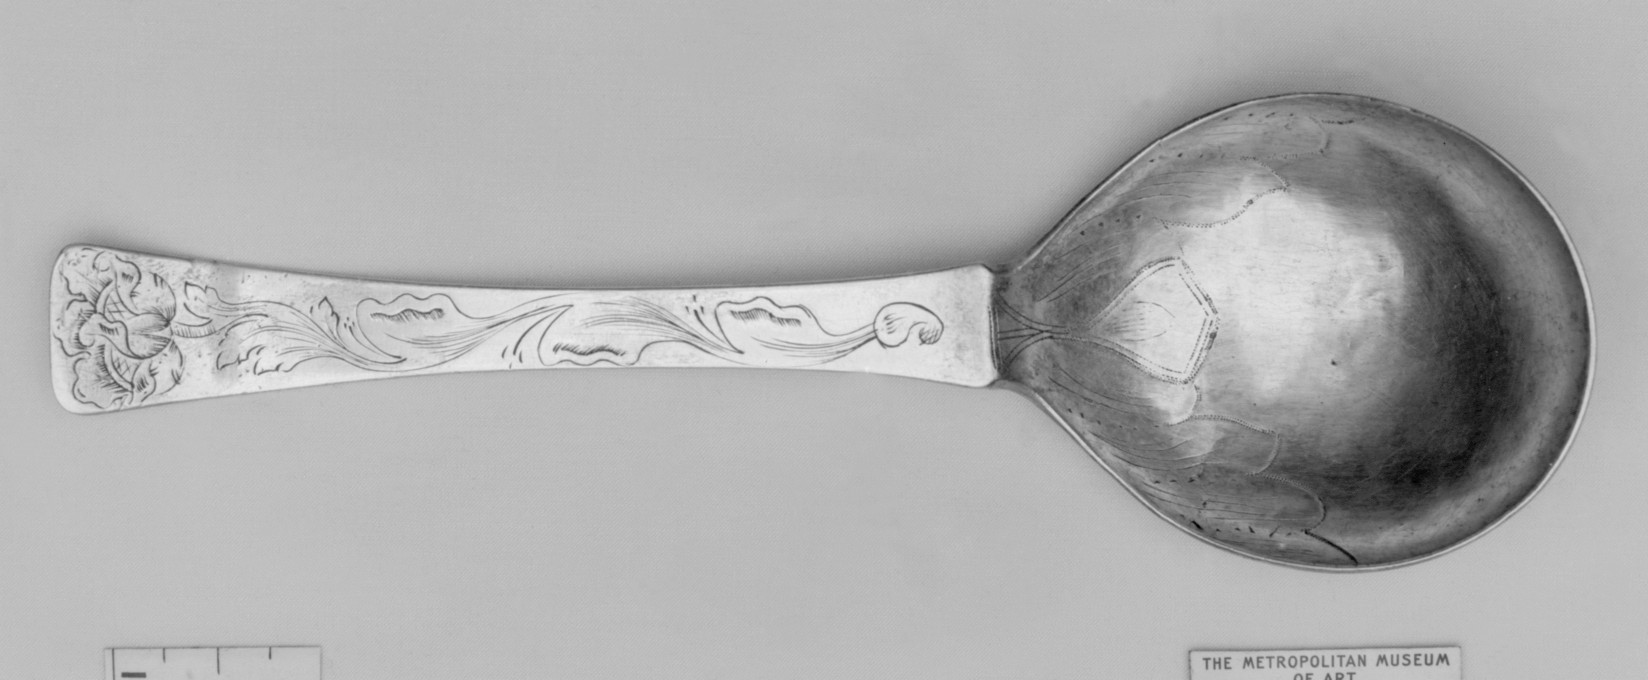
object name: spoon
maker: thomas nilsen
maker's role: maker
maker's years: 1634-1674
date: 1651-1675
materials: silver